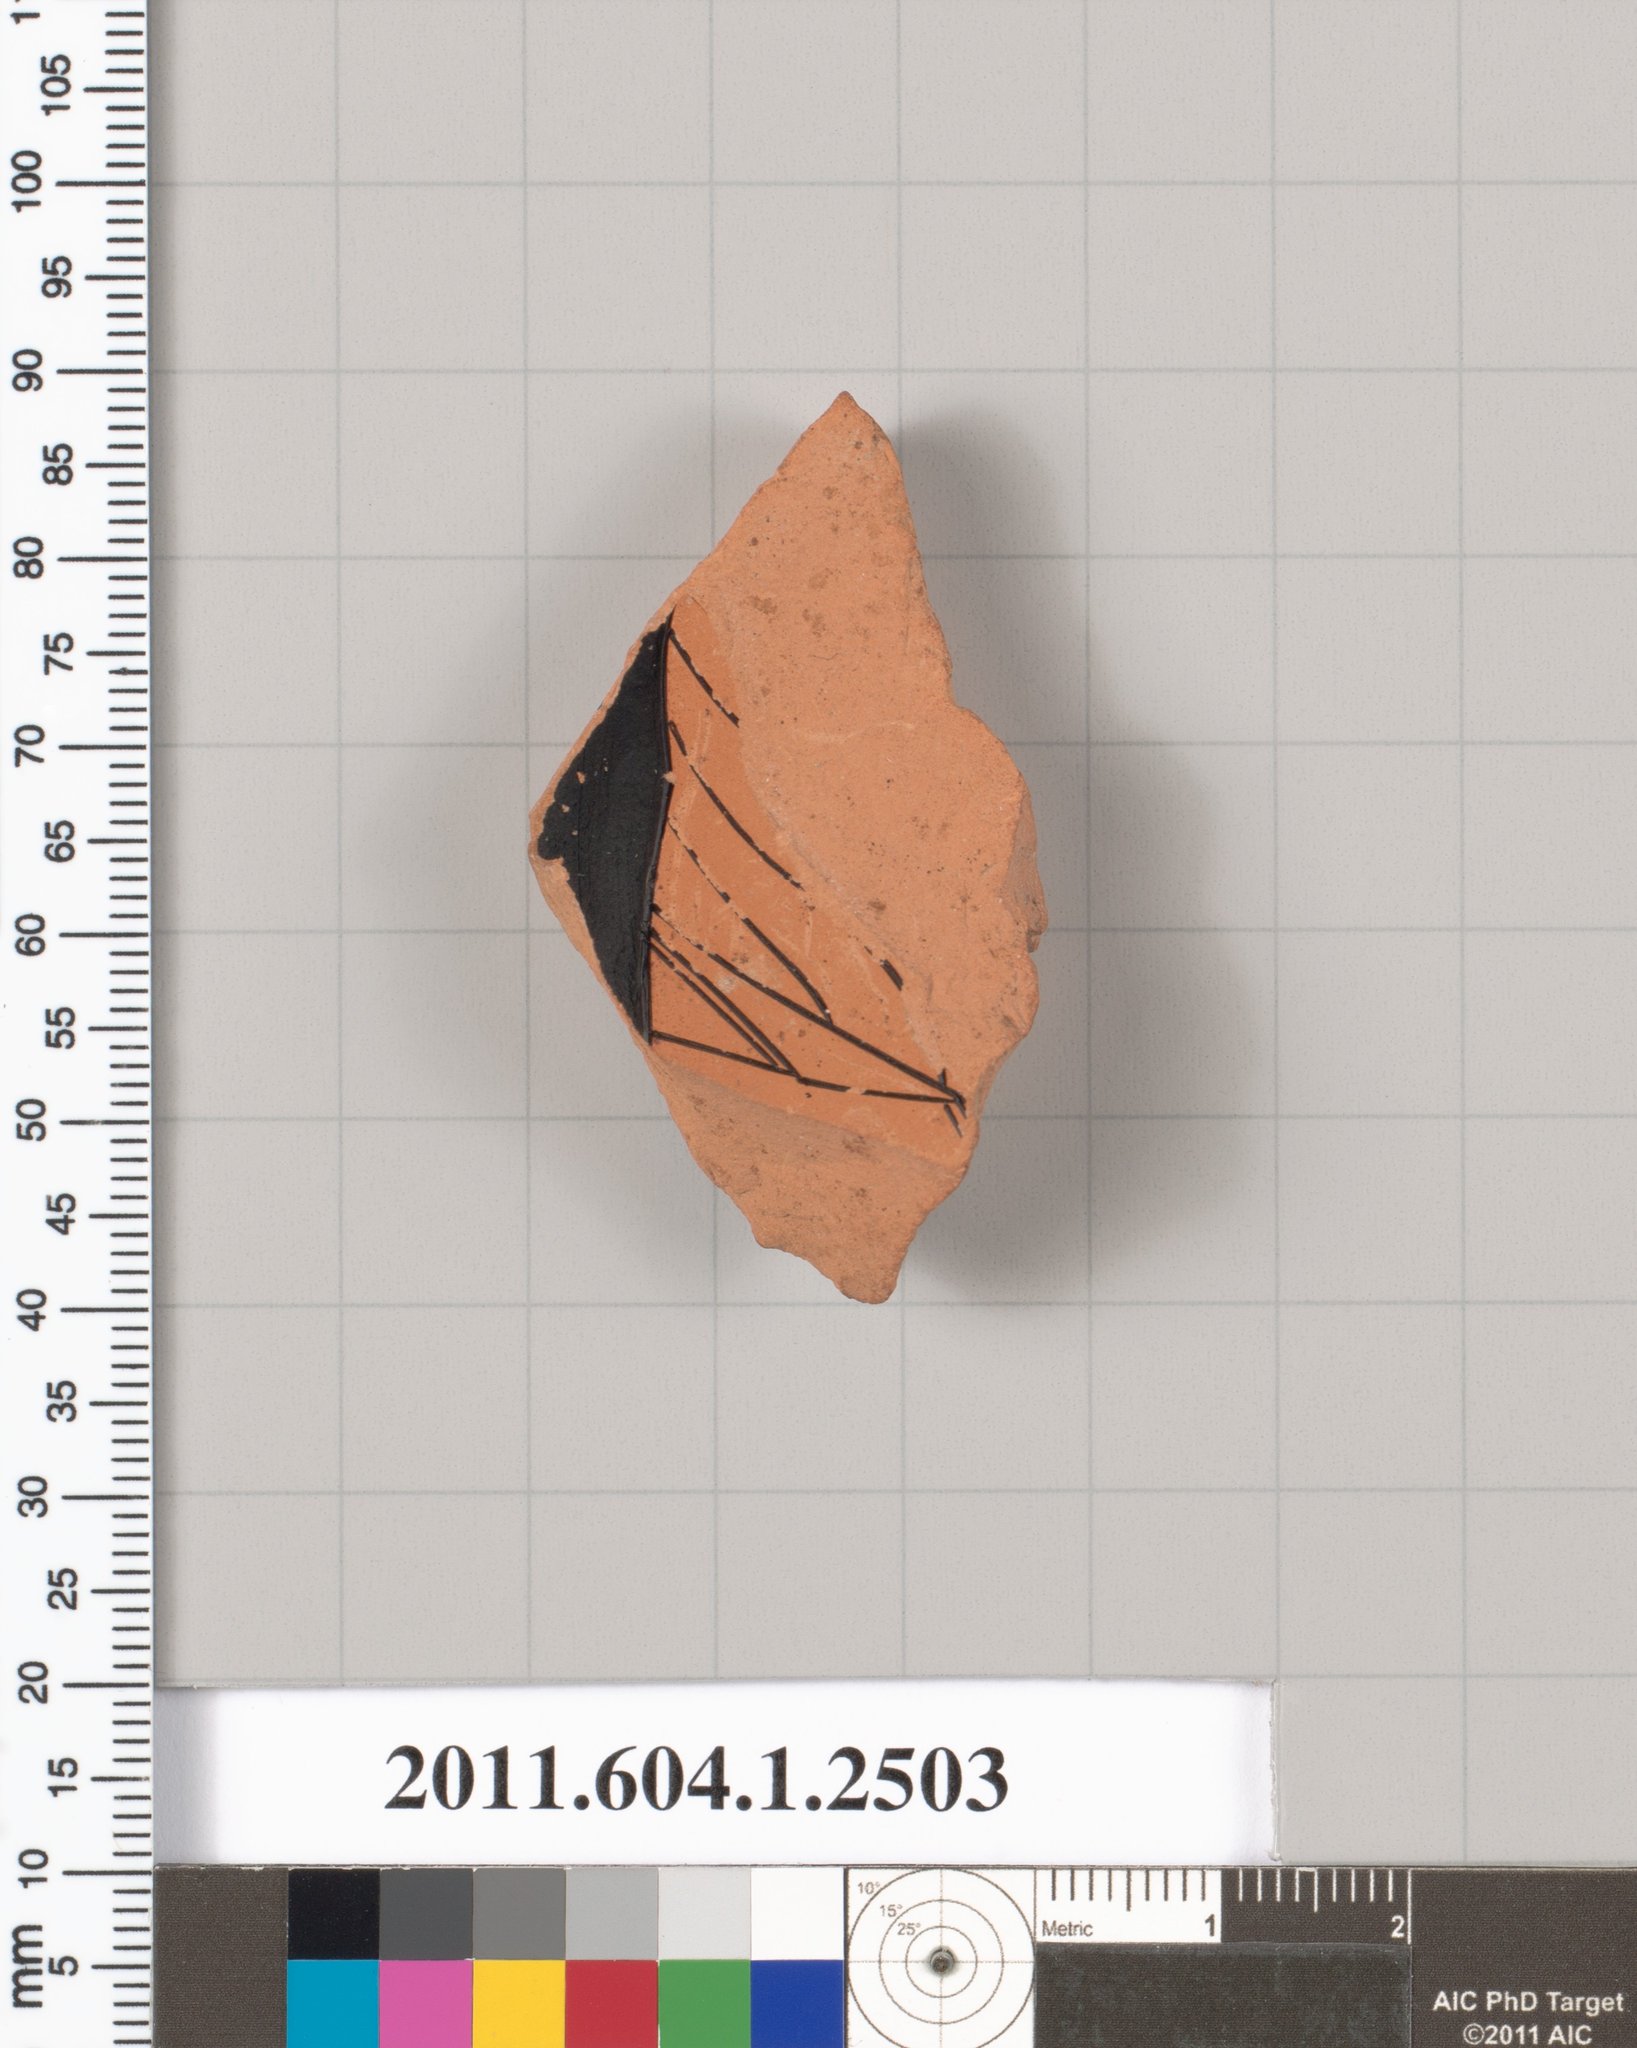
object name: kylix fragment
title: Terracotta fragment of a kylix (drinking cup)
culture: greek, attic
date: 490-480 BCE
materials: terracotta